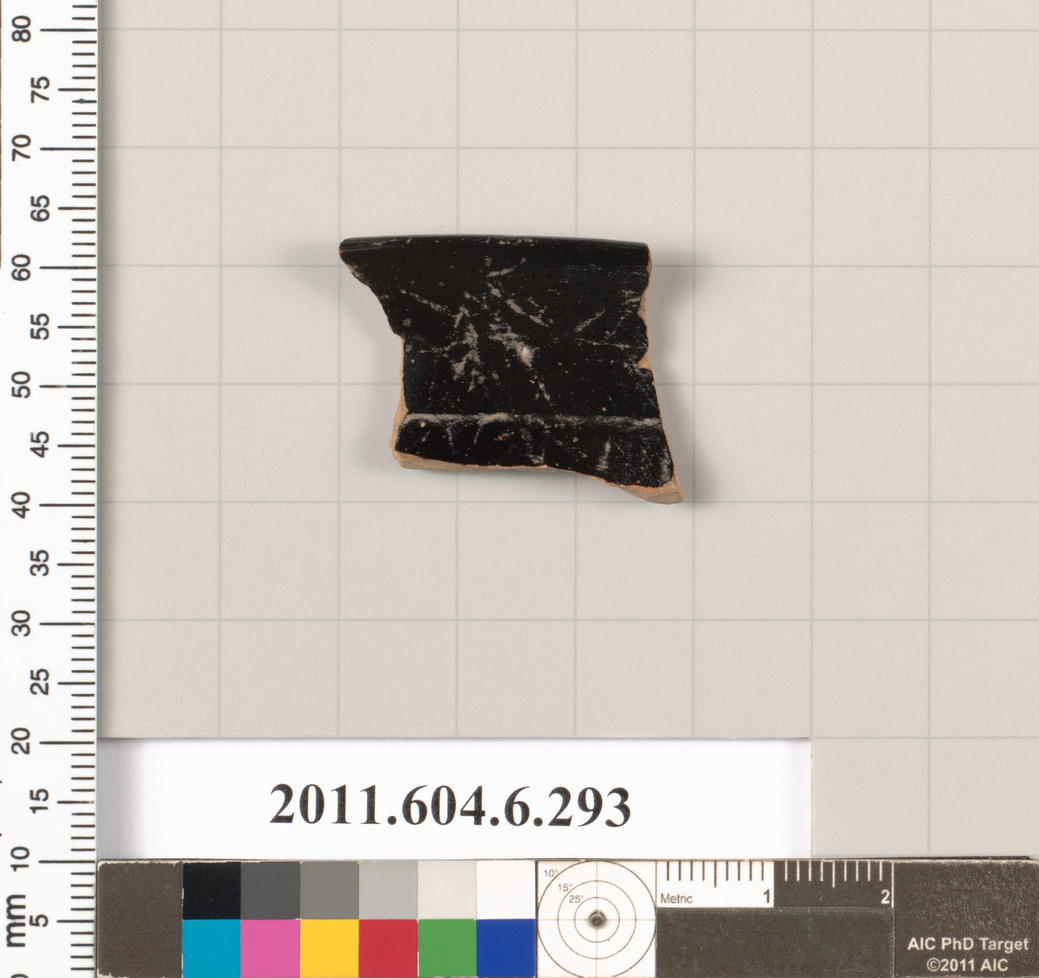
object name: calyx cup fragment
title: Terracotta fragment of a calyx-cup?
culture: greek, attic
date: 367-335 BCE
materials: terracotta